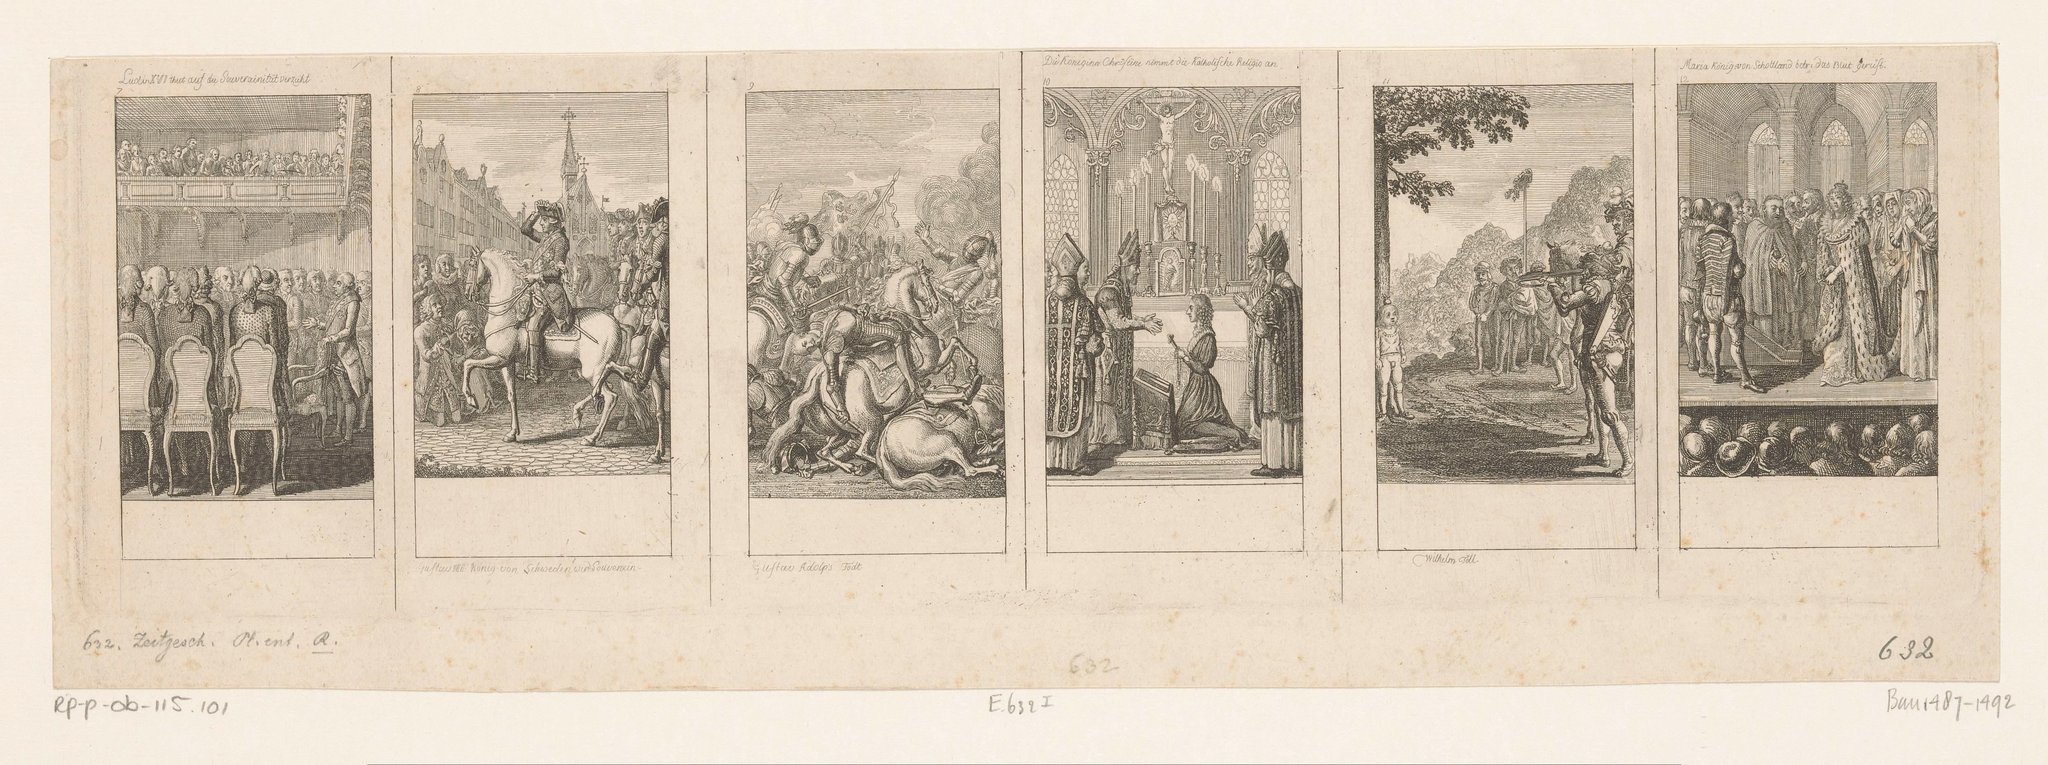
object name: print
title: Zes voorstellingen uit de oudere, middelste en nieuwere geschiedenis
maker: daniel nikolaus chodowiecki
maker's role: draughtsman, print maker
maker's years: 1726-1801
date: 1790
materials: paper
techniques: etching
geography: berlin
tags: rome, christina (koningin van zweden), paris, lodewijk xvi (koning van frankrijk), william tell, priest (roman catholic), history, coronation of a ruler, battle, horse, meeting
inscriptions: collector's mark: Lugt 2228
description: Latere staat gebruikt voor: Gothaischer Hof Kalender zum Nutzen und Vergnügen eingerichtet auf das Jahr 1791. Gotha: C. W. Ettinger, [1790].